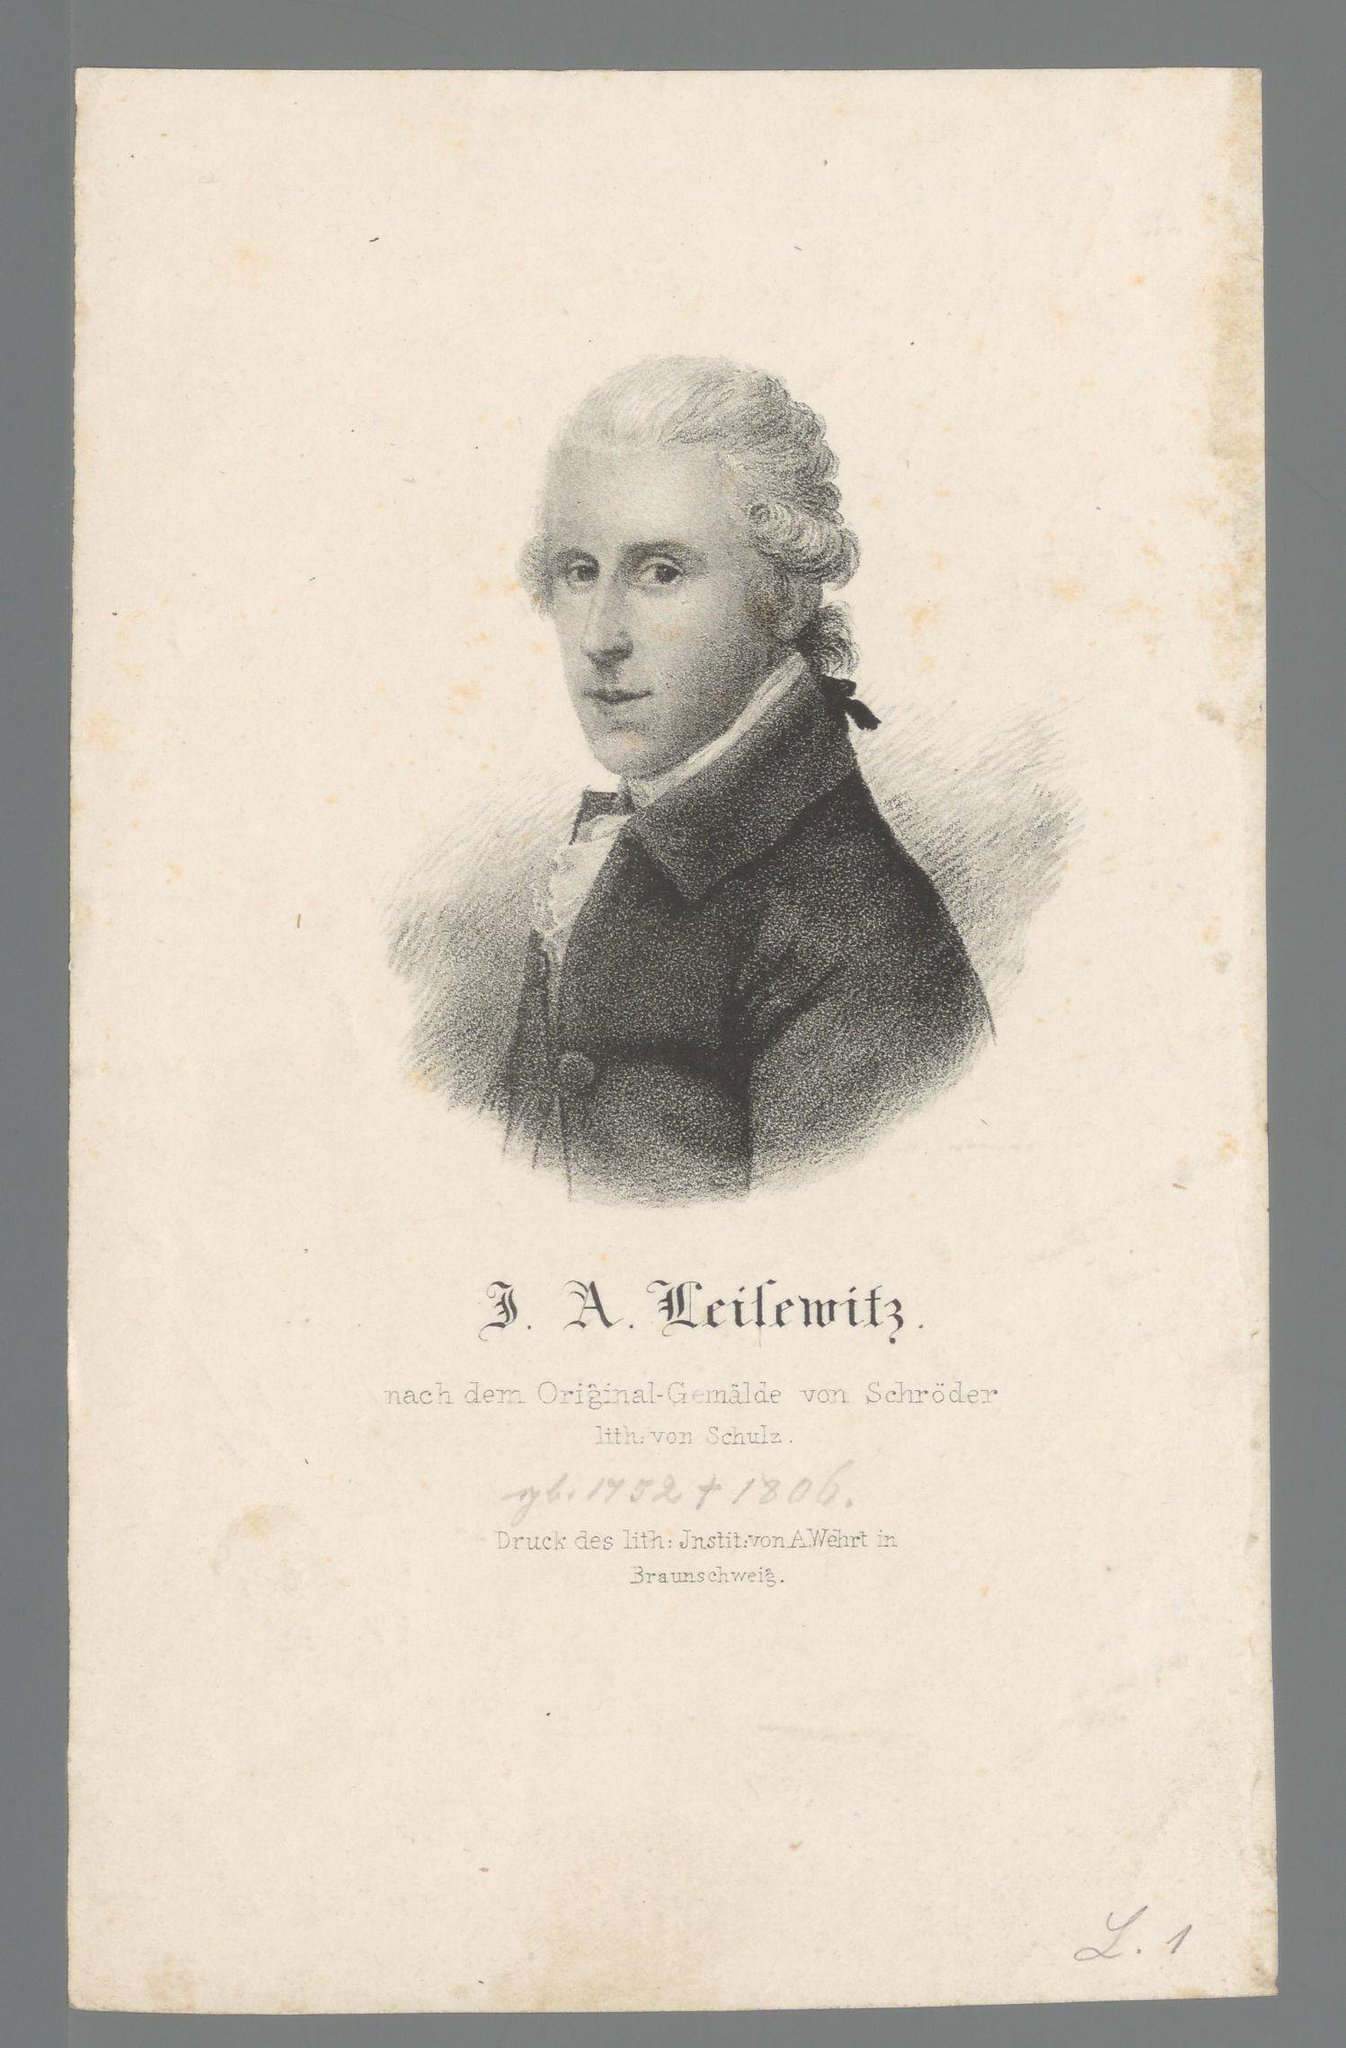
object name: print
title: Portret van Johann Anton Leisewitz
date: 1820-1880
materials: paper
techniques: lithograph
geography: braunschweig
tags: theatre, theatrical performance, historical persons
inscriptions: collector's mark: Lugt 2228